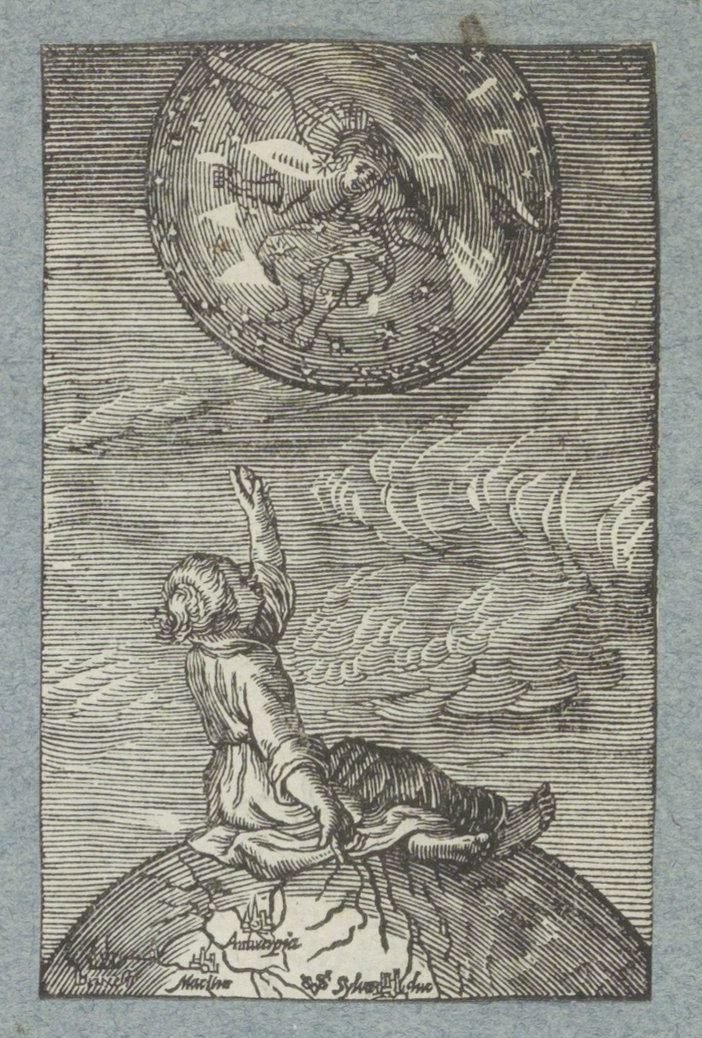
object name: print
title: Pia Desideria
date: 1628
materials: paper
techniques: woodcut, pasting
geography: amsterdam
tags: sphere, globe ~ stereometry, star-globe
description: Prent uit: Herman Hugo, Pia desideria emblematis, elegiis & affectibus S. S. Patrum illustrata, Antwerpen 1628. Volgens de titelpagina verscheen dit werk in Antwerpen bij Hendrick Aertssens, in werkelijkheid verscheen het in Amsterdam bij Pieter Jacobsz Paets (Dietz 2012, p. 58-59).